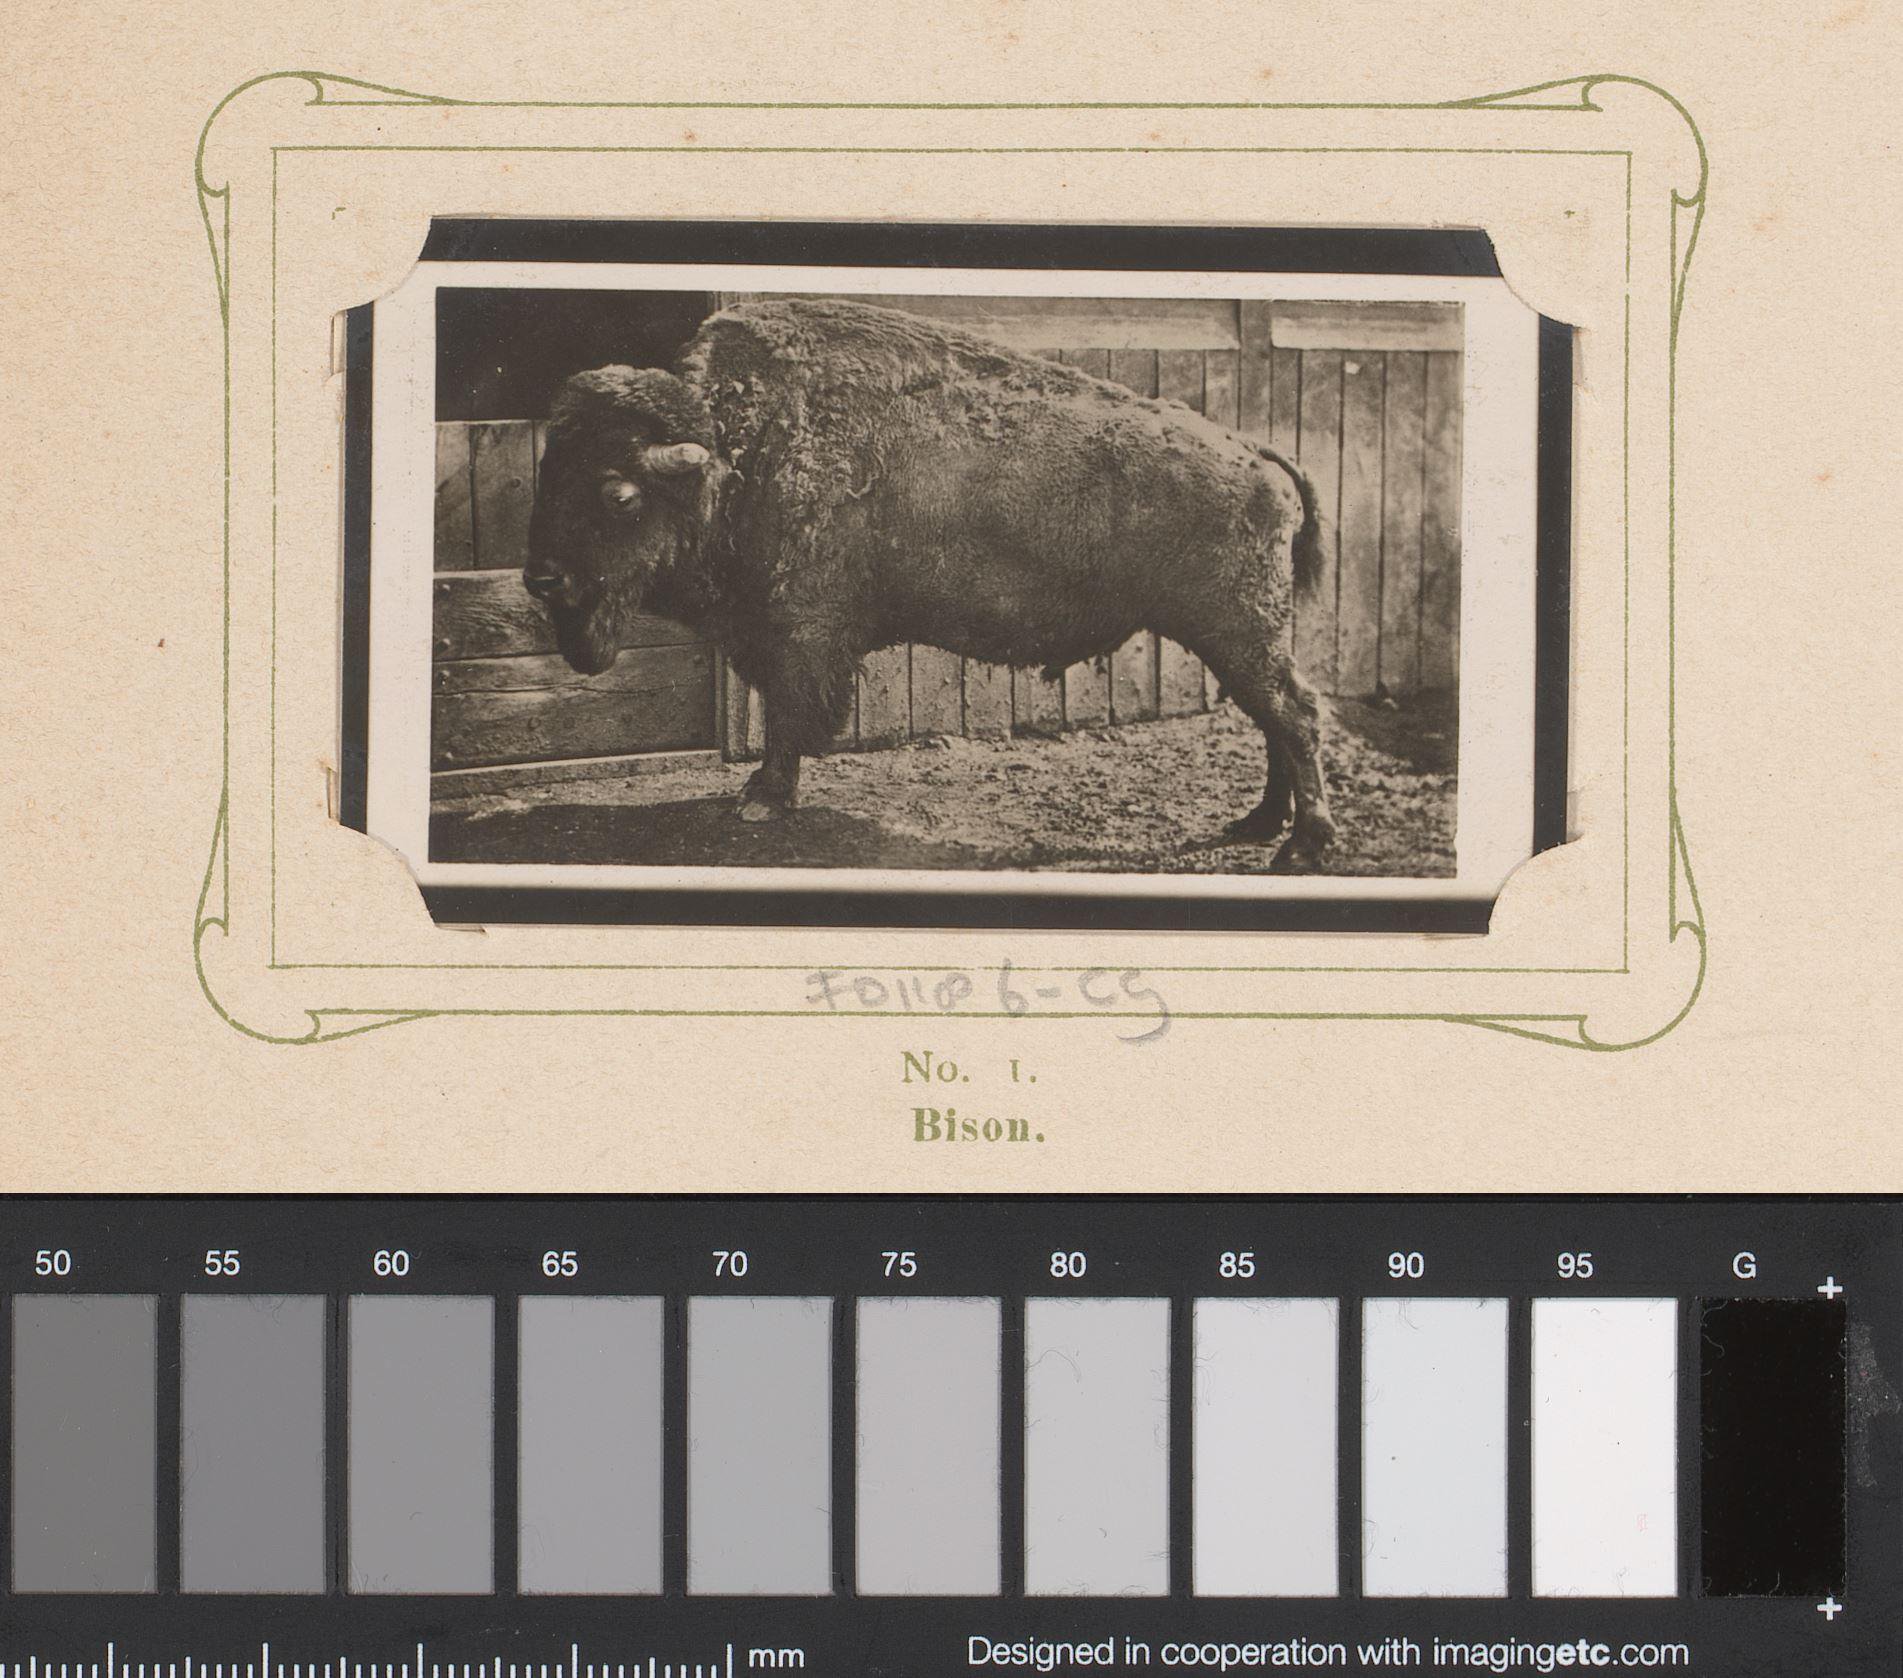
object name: photograph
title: Bison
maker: Anonymous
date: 1904-1905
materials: photographic support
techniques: gelatin silver print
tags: hoofed animals: bison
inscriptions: inscription: ‘No. 1./ Bison.’